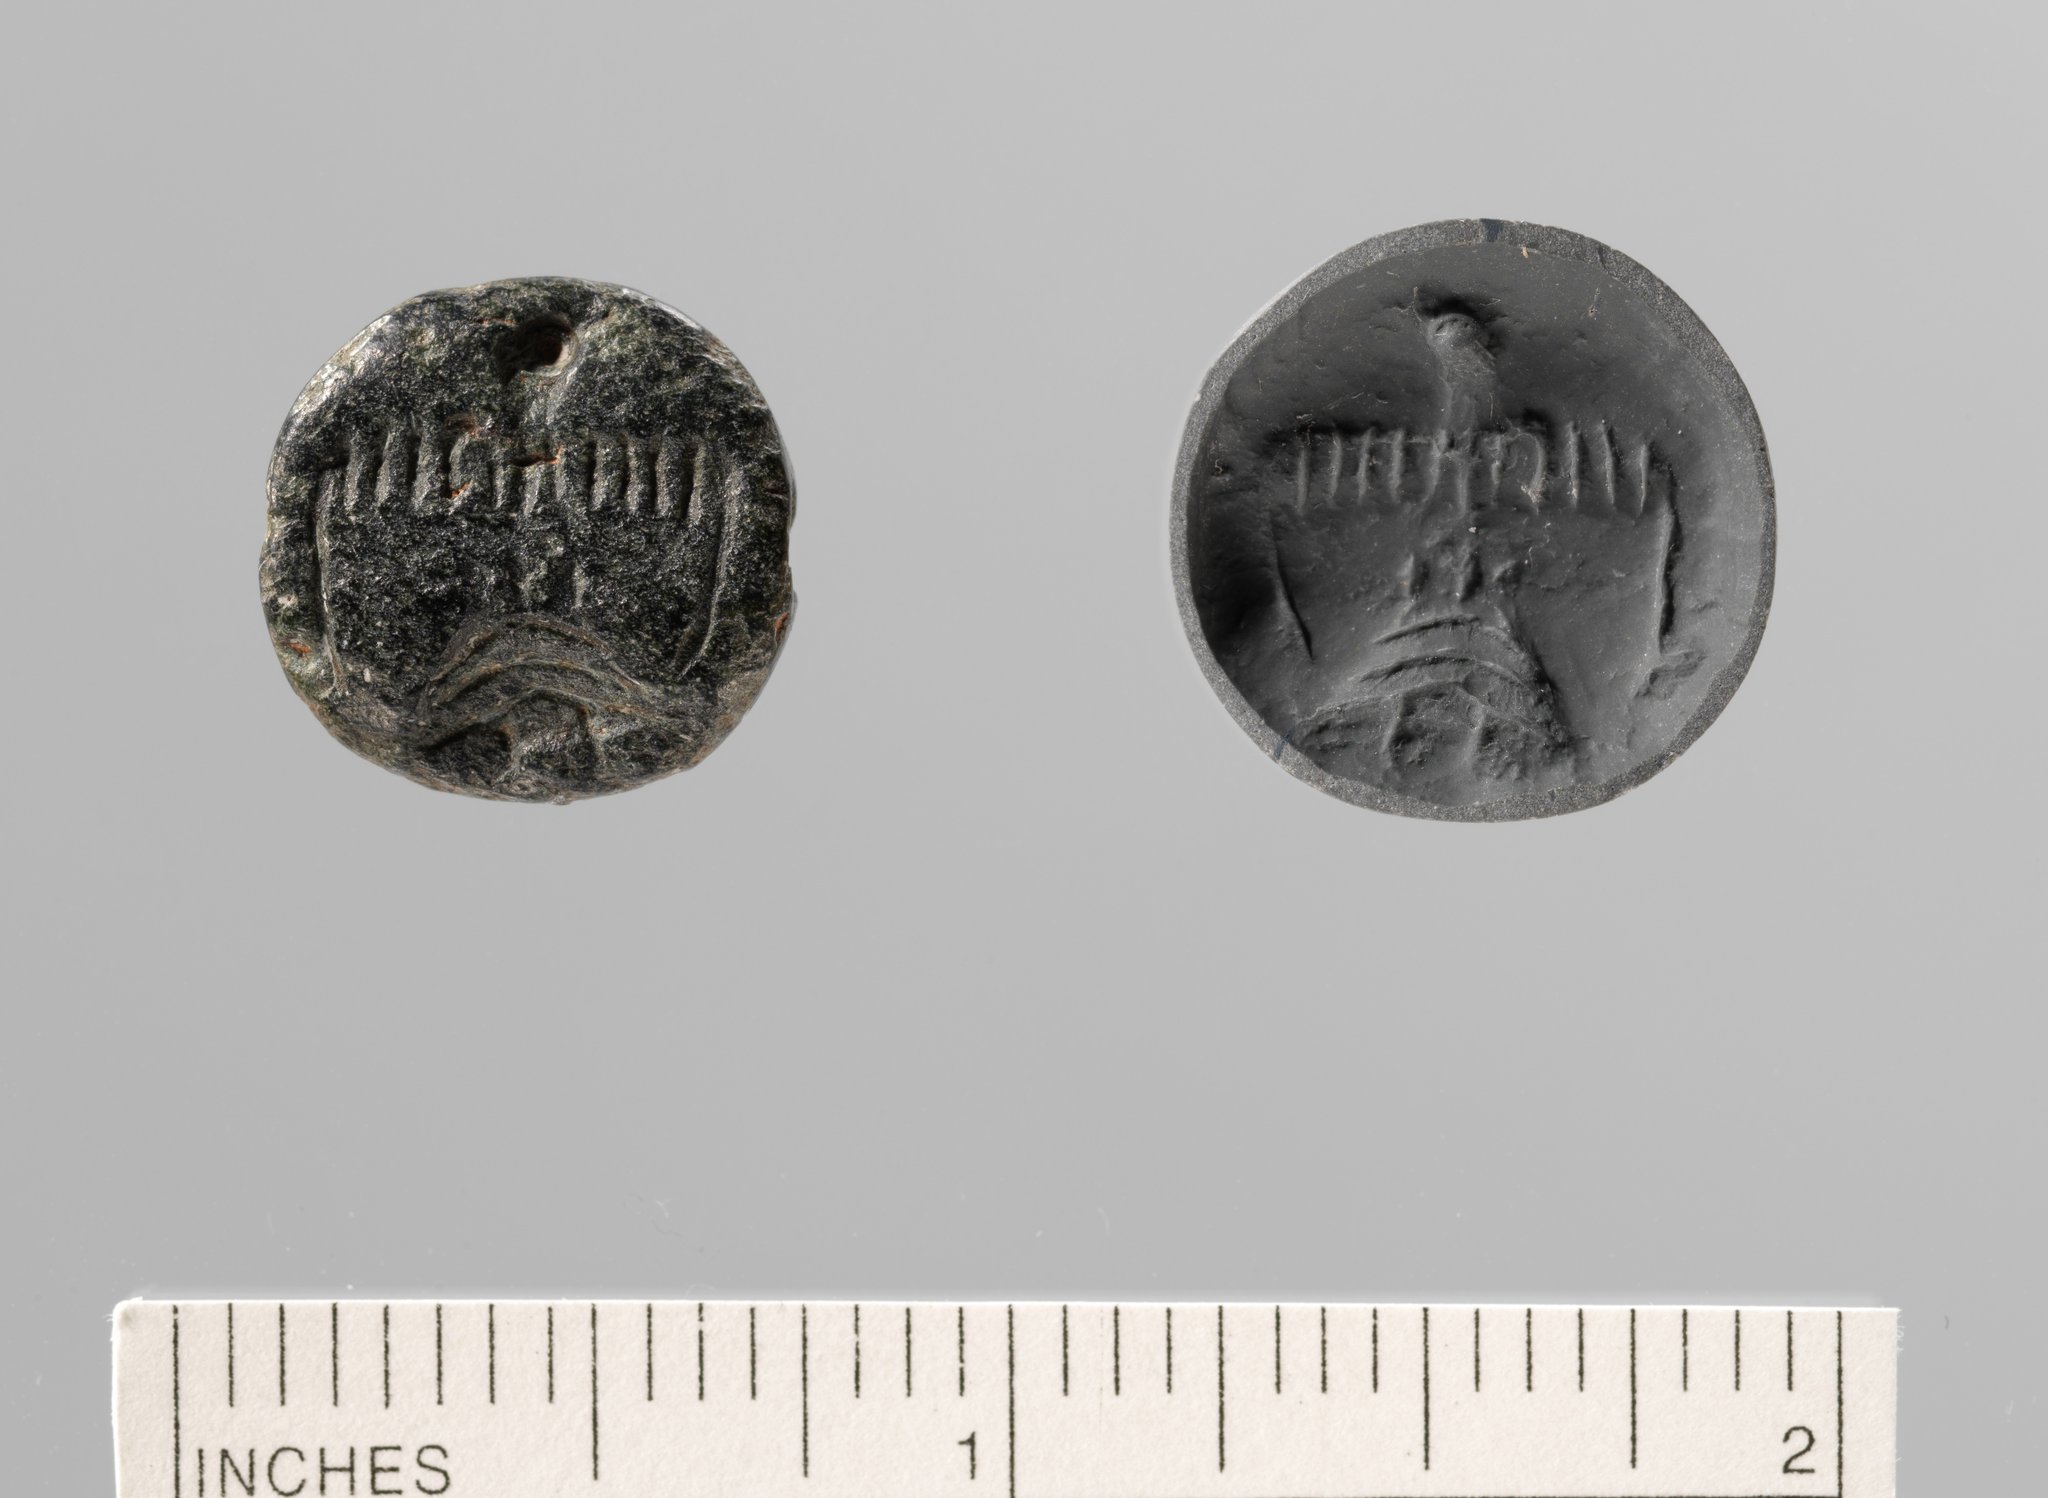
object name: seal, lentoid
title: Steatite Lentoid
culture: minoan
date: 1350-1200 BCE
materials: stone